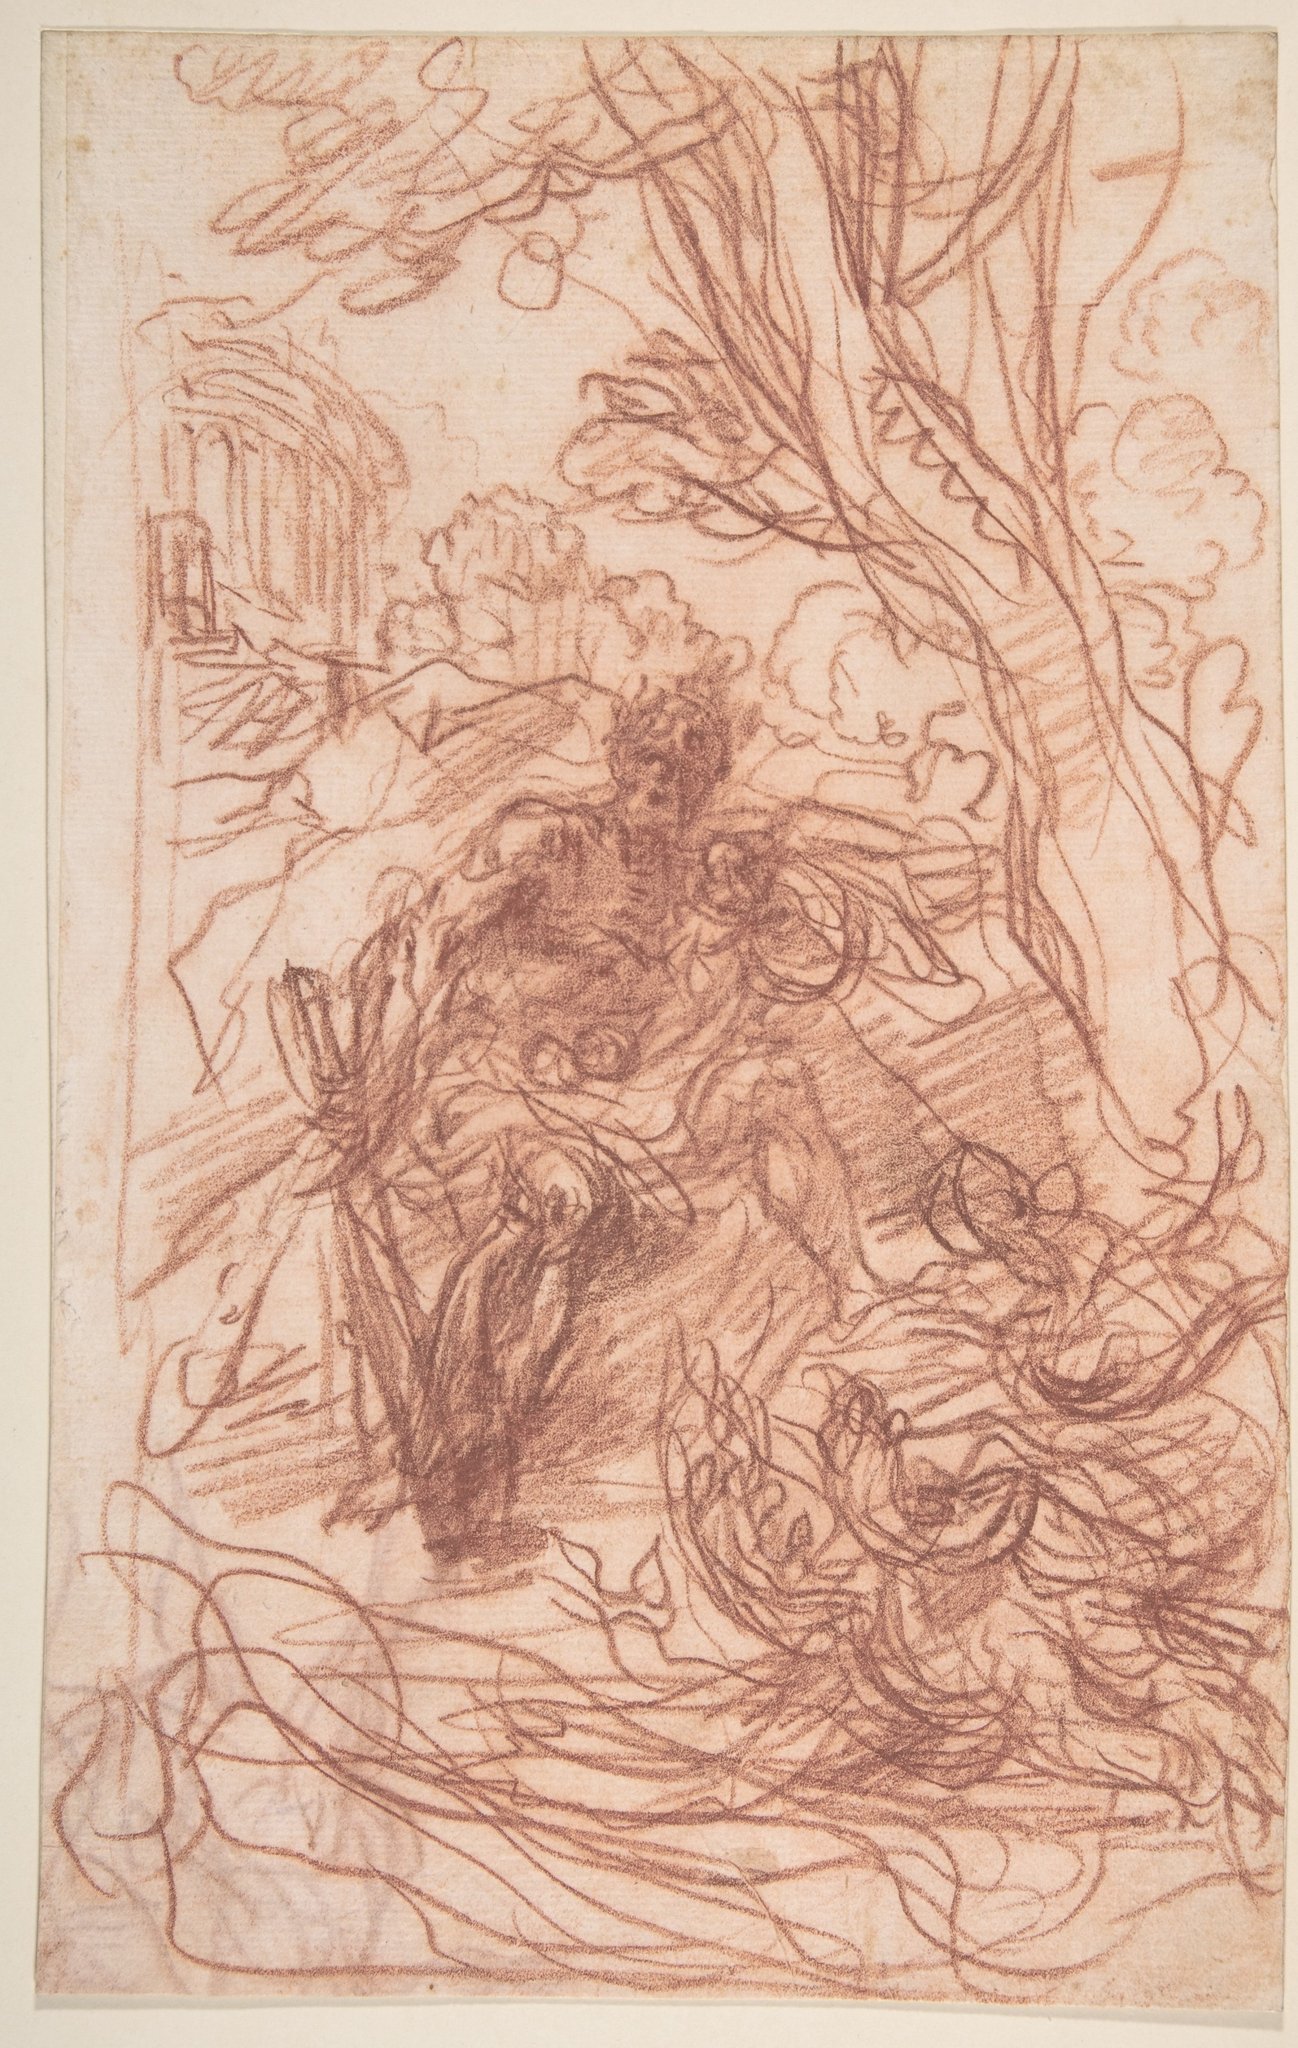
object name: drawing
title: Hercules in the Garden of the Hesperides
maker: baldassarre franceschini (il volterrano)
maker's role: artist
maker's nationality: italian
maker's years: 1611-1690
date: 1612-1656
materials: chalk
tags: hercules,trees